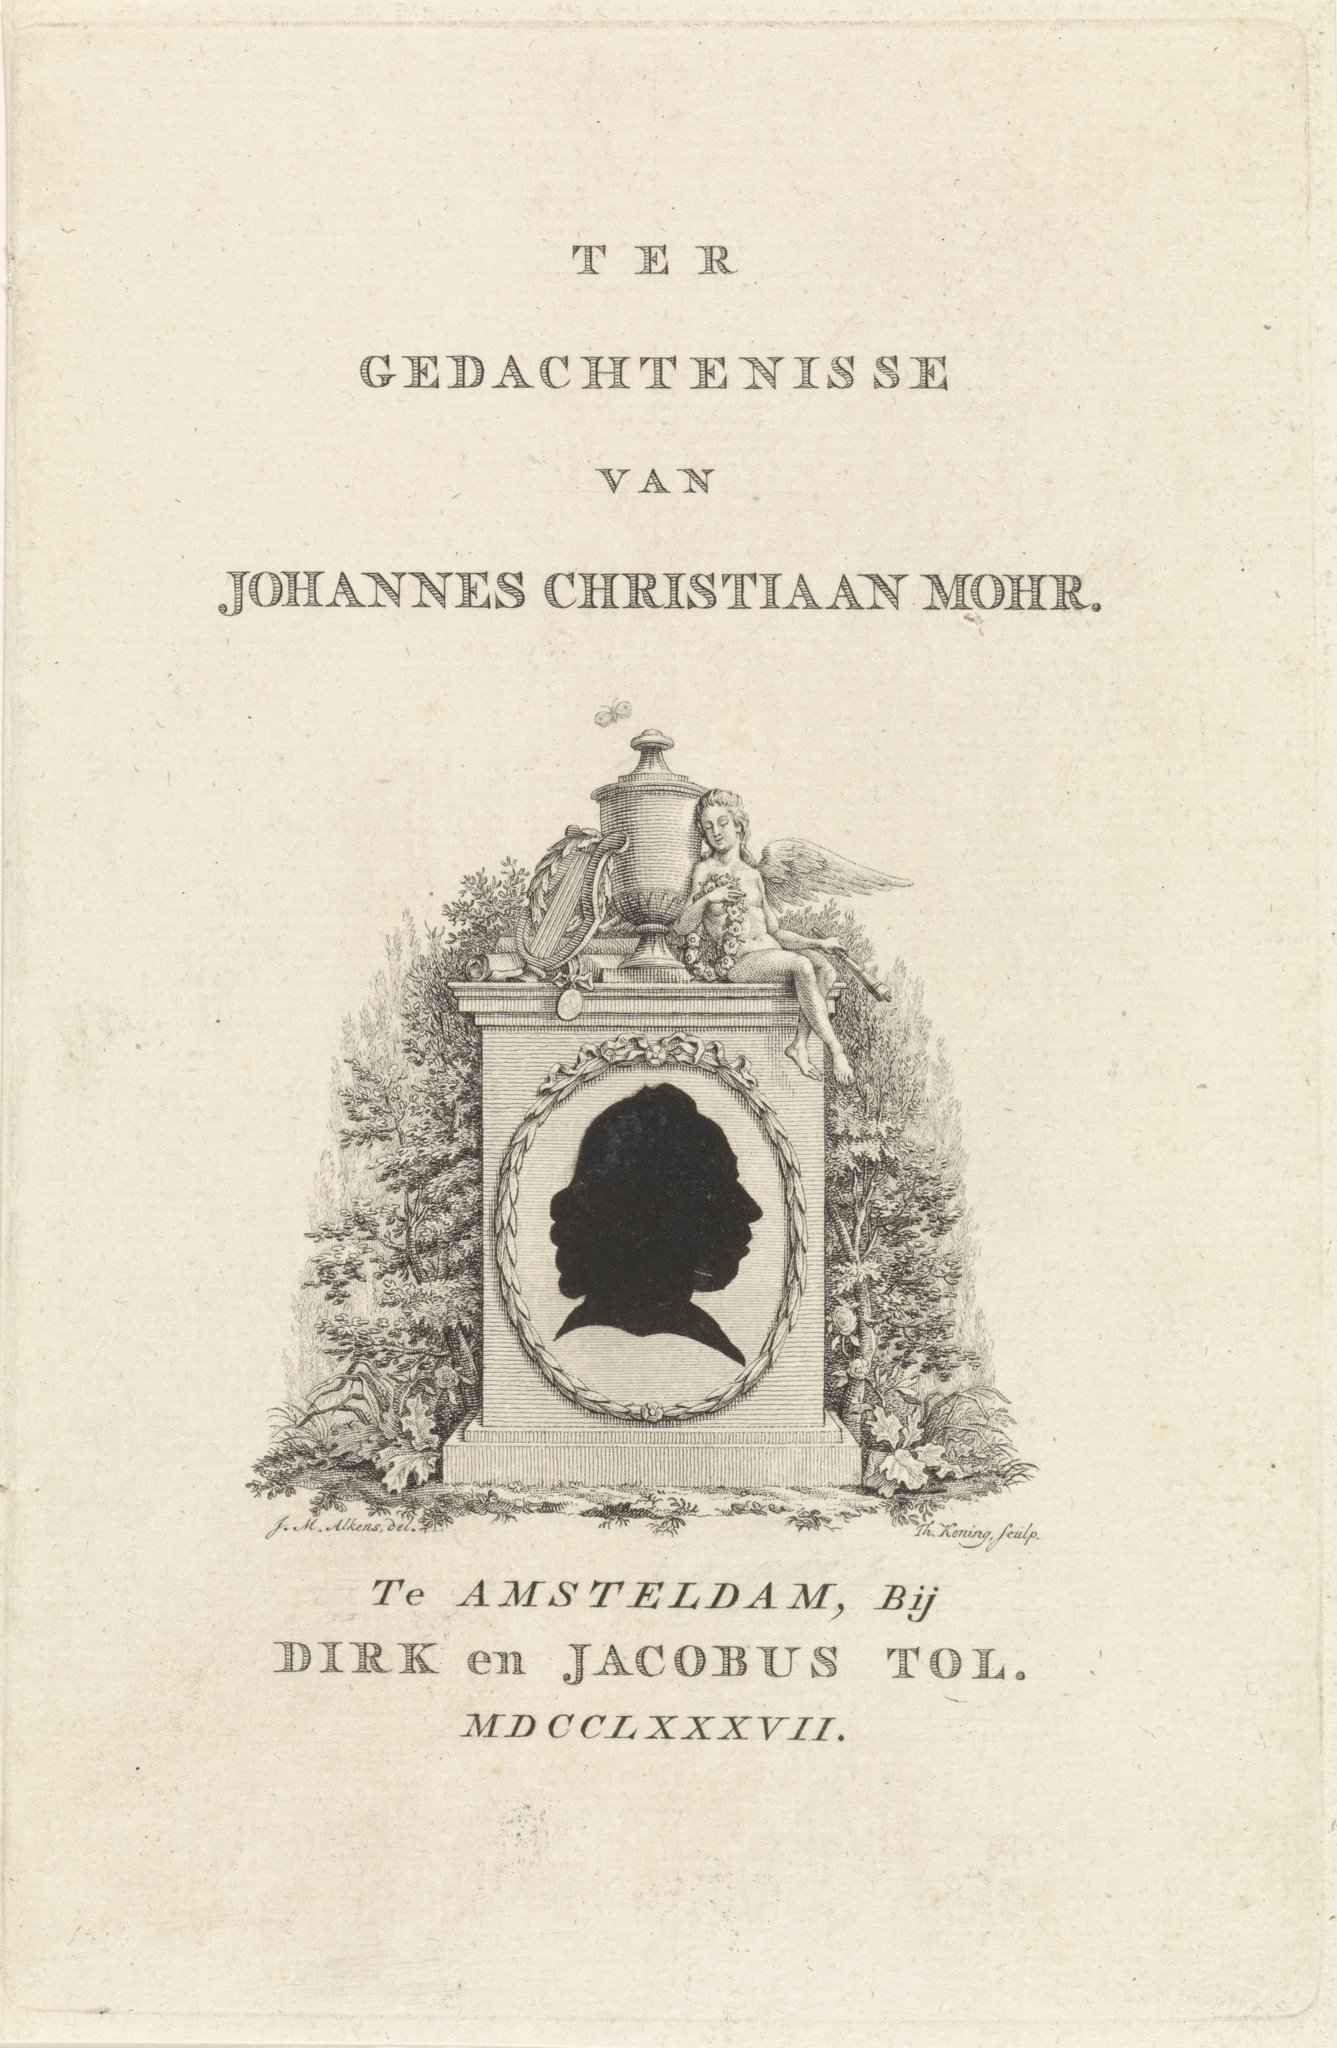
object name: print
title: Gedenkteken voor Johannes Christiaan Mohr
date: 1787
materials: paper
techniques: etching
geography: amsterdam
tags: johannes christiaan mohr, other memorial structures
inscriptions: collector's mark: Lugt 2228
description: Allegorisch gedenkteken voor de dichter Johannes Christiaan Mohr. In het midden het monument met daarop het silhouetportret van Mohr, in een ovale omlijsting naar rechts. Op het monument een harp, bokaal, lauwerkrans, enkele brieven, medailles en een engeltje.